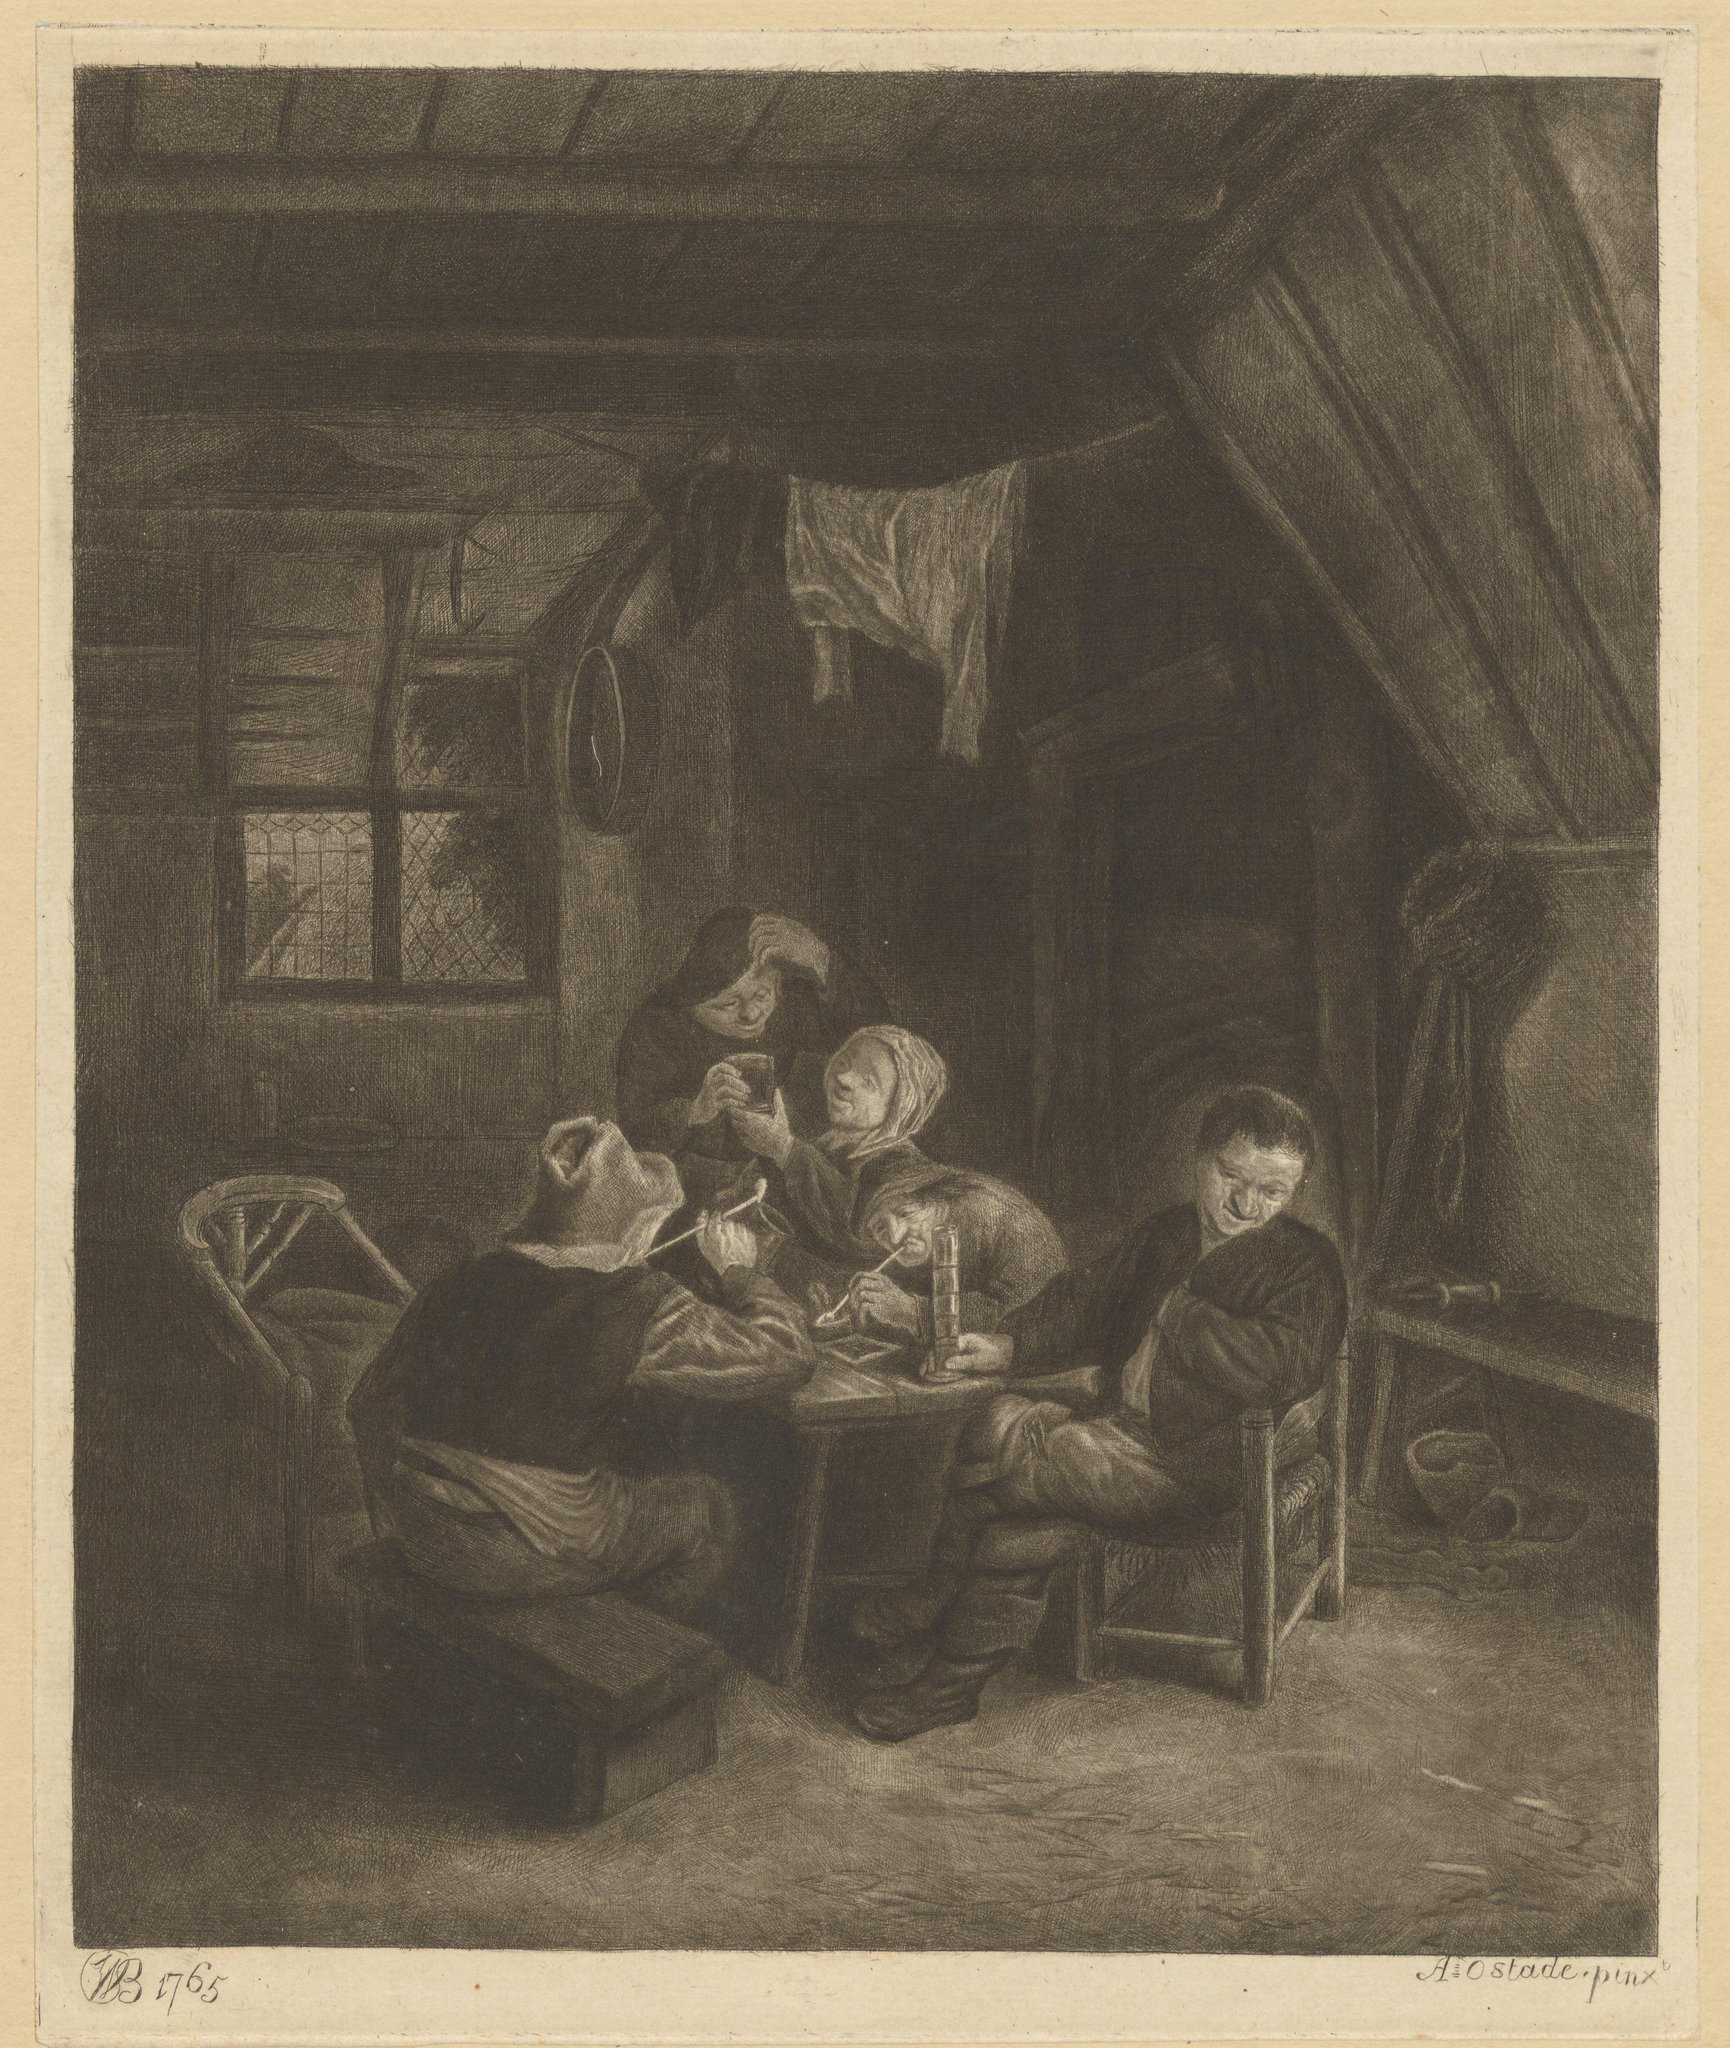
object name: print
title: Boereninterieur met vijf drinkende en rokende figuren om een tafel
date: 1765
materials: paper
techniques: etching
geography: england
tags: pipe ~ tobacco, farmers, farm (building) - aa - civic architecture: inside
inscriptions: collector's mark: Lugt 240